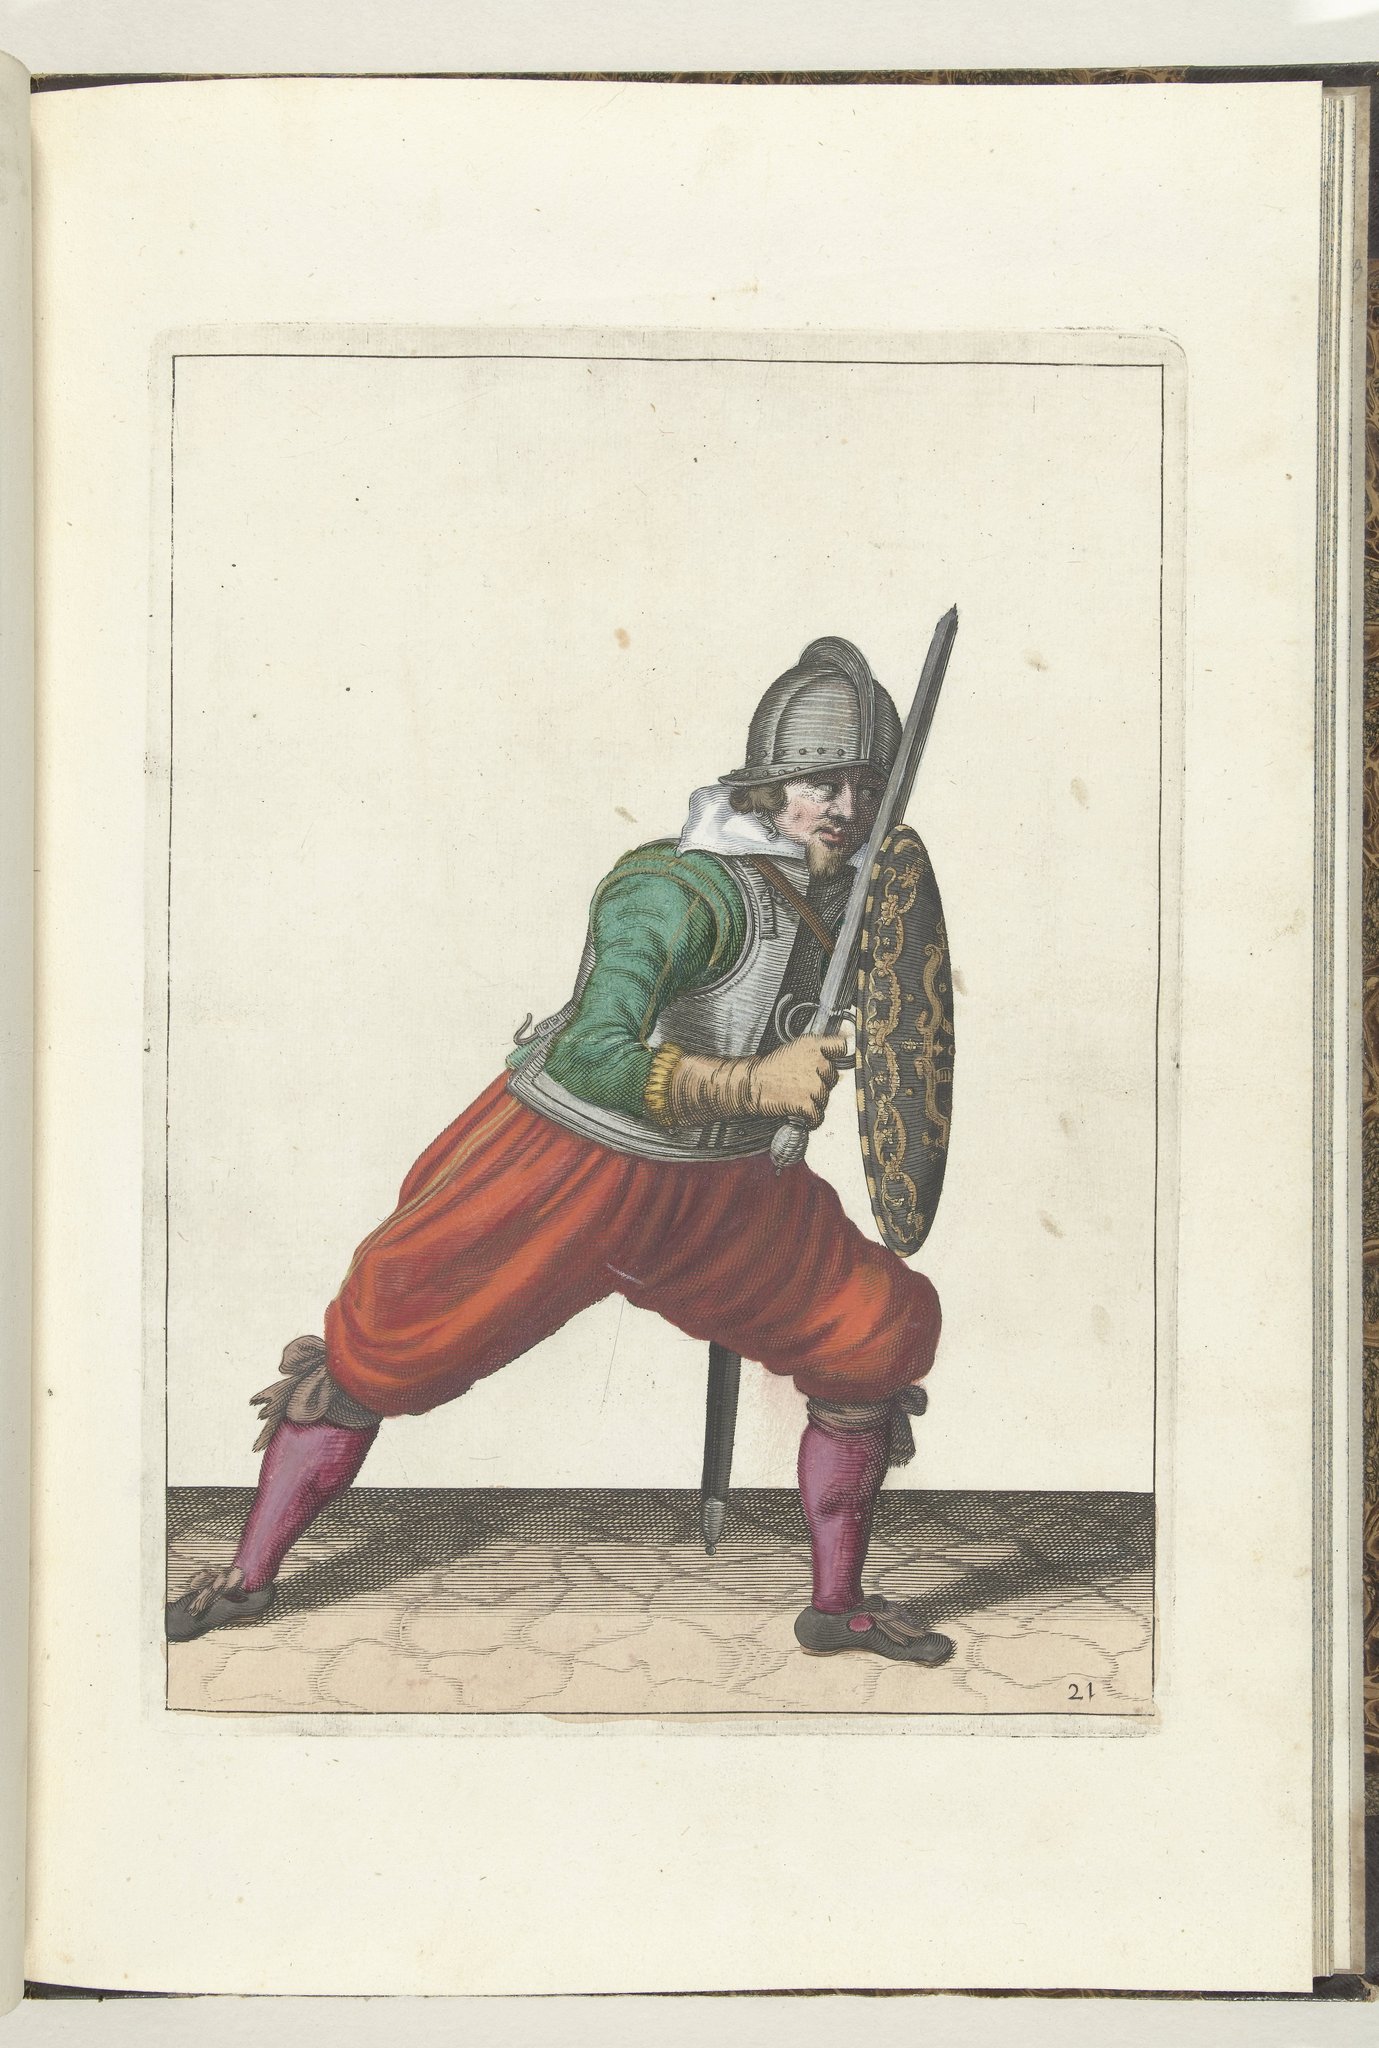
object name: print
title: De exercitie met schild en spies: de soldaat in een verdedigende houding met een voet naar voren en met zijn rapier en schild op de knie voor het lichaam (nr. 21), 1618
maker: Anonymous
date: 1616-1618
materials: paper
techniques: engraving, hand coloring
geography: northern netherlands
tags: maurice (prince of orange), handling of weapons ~ military training, weapons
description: Illustratie in: Adam van Breen, Nassauische Waffenhandelung [incompleet exemplaar], 1618?, plaat 21. Dit is een Duitse editie van Adam van Breens De Nassausche Wapen-Handelinge, van Schilt, Spies, Rappier ende Targe : beyde figuerlick afgebeelt, ende gestelt na de nieu ordening [van] ... Maurits van Nassau, 's-Gravenhage, [Aert Meuris] 1618. In het exemplaar in de collectie van de Rijksmuseum Research Library (326 F 23).